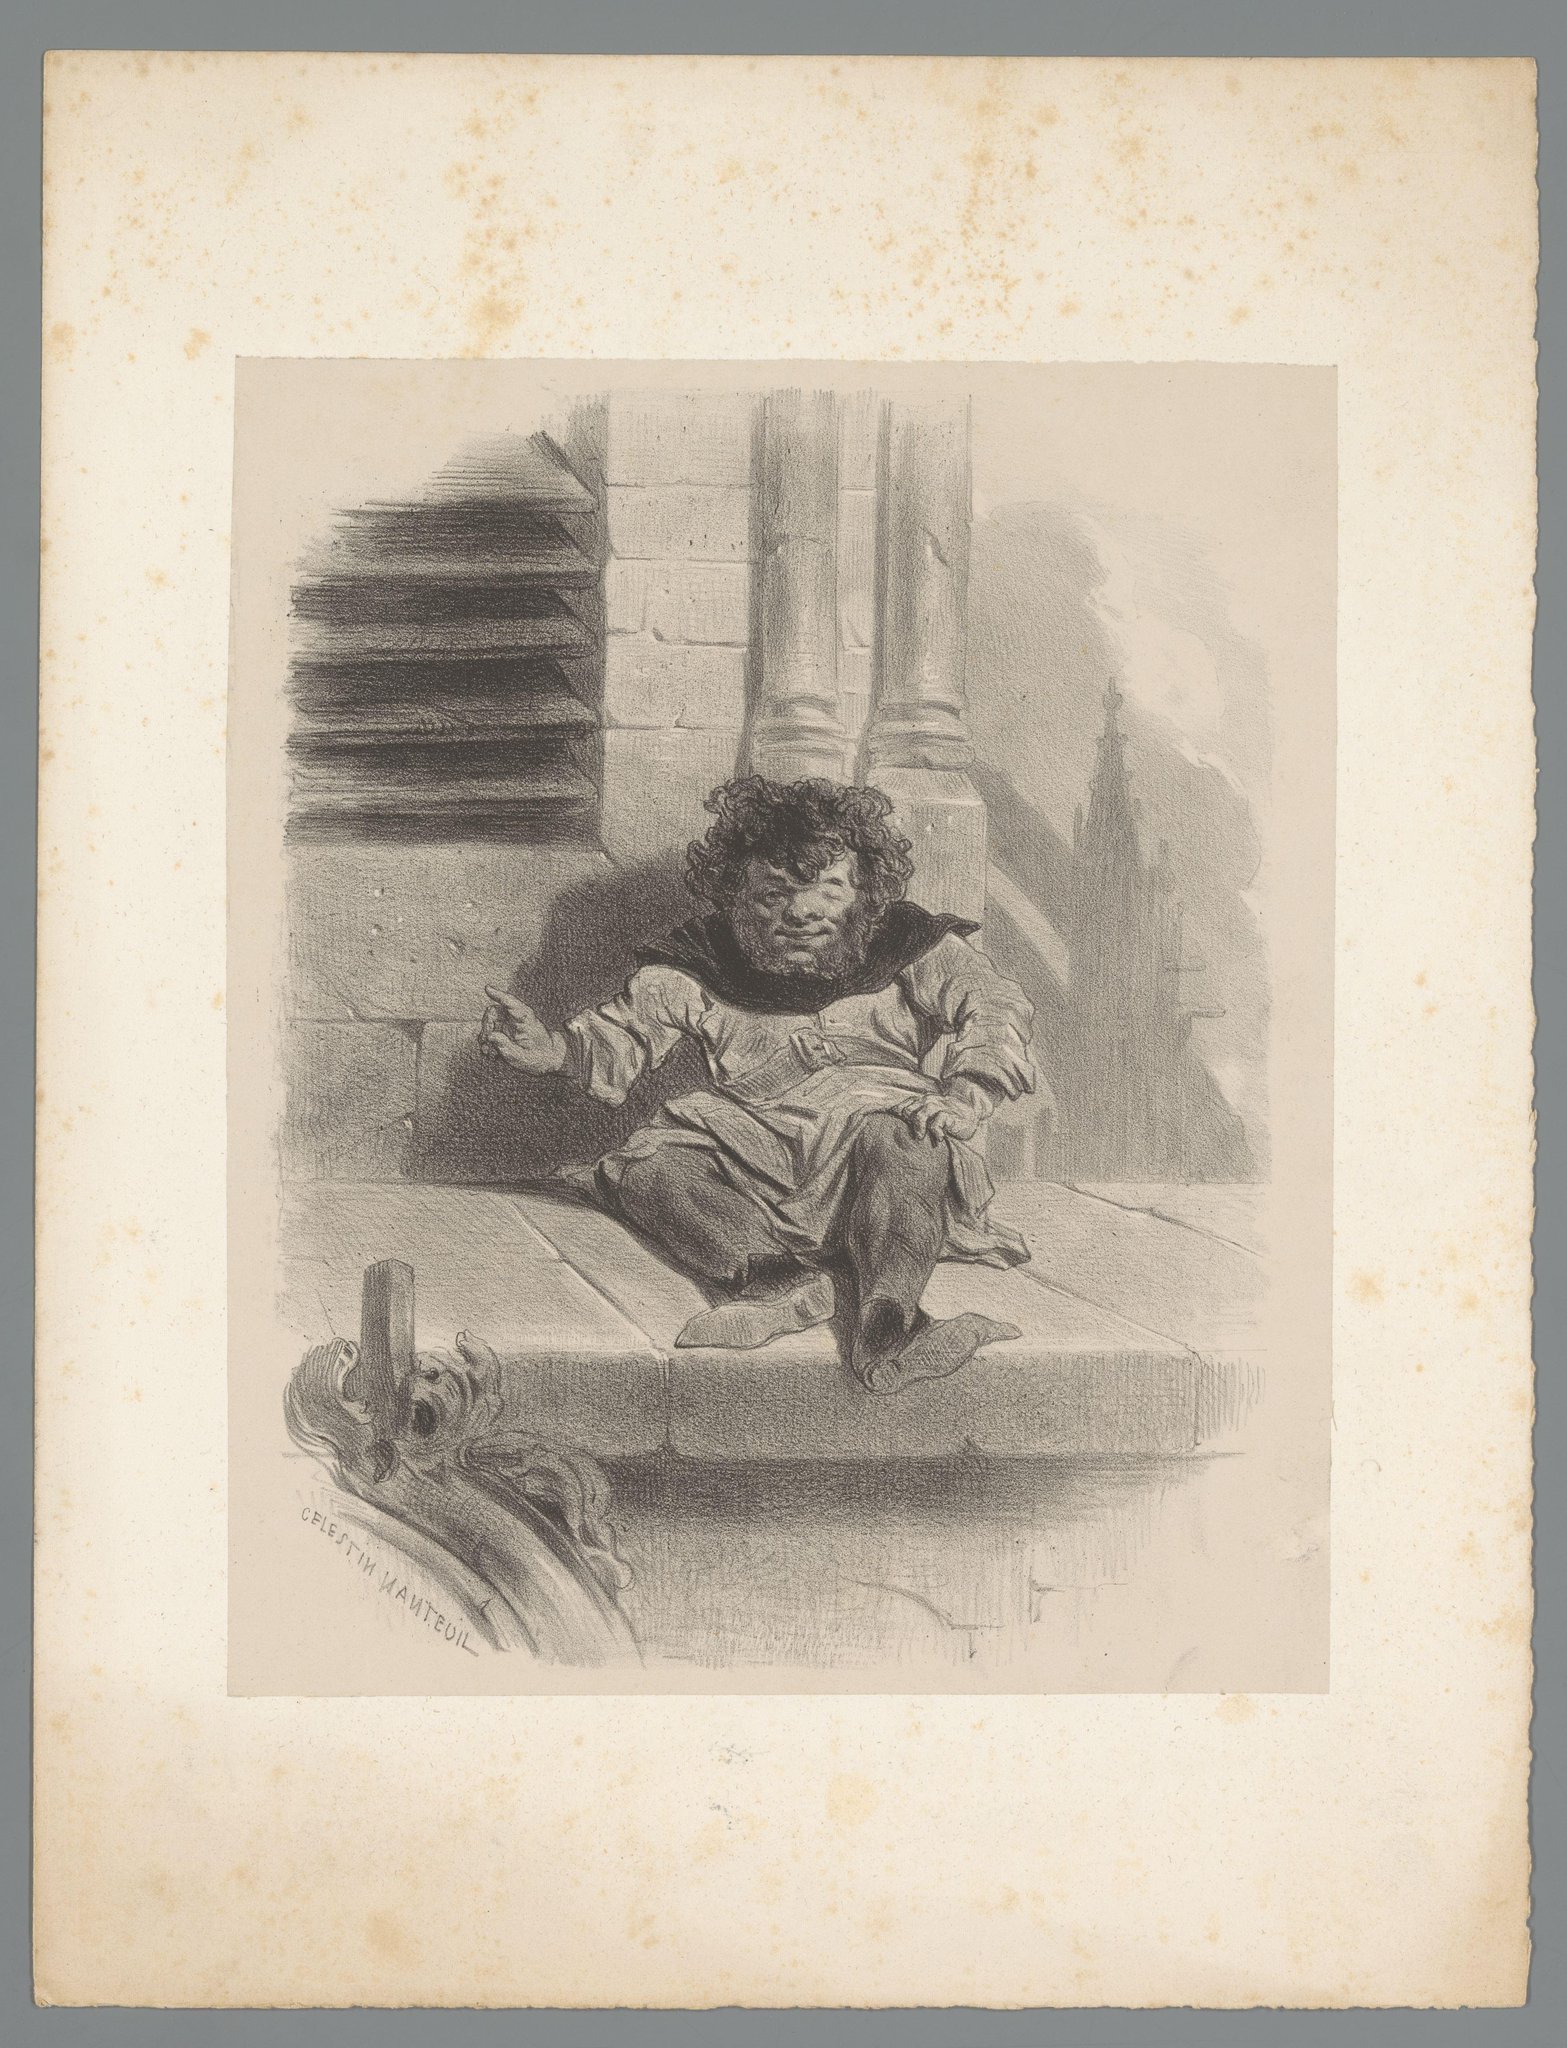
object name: print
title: Zittende kleine man die knipoogt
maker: célestin françois nanteuil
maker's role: print maker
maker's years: 1813-1873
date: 1823-1873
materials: paper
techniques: lithograph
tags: little people, one eye closed, winking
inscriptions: collector's mark: Lugt 964